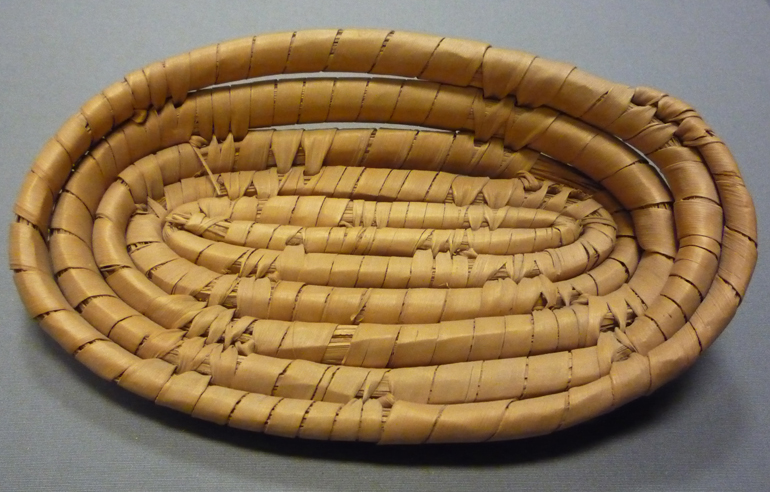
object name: basket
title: Model Basket from a Foundation Deposit for Hatshepsut's Temple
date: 1479-1458 BCE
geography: egypt